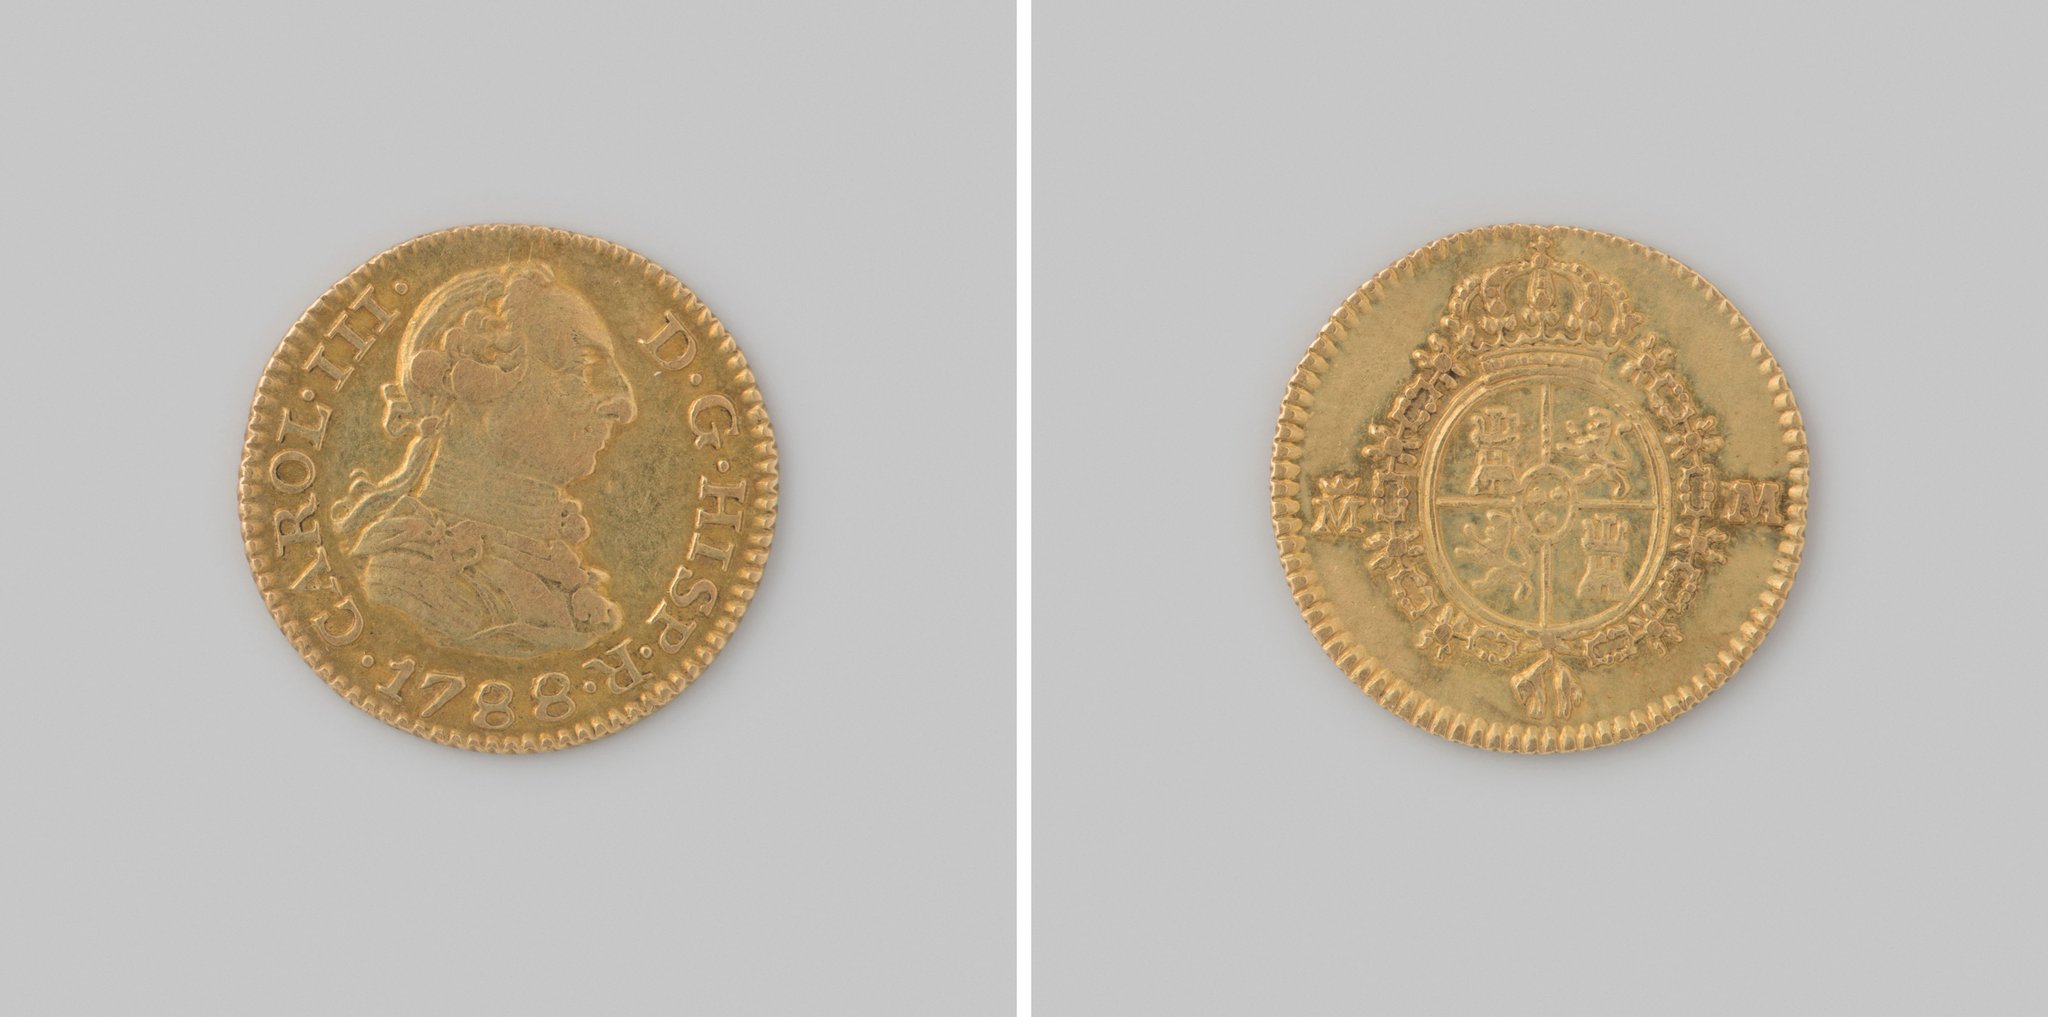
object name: coin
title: halve escudo uit Spanje van koning Karel III,1788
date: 1788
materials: gold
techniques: striking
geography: madrid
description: Gouden munt. Voorzijde: borstbeeld van de koning naar rechts. Keerzijde: ovaal gekroond, met keten en juweel van de orde van het gulden vlies omhangen wapenschild. Links daarvan gekroonde letter M [=Madrid]. Kartelrand.